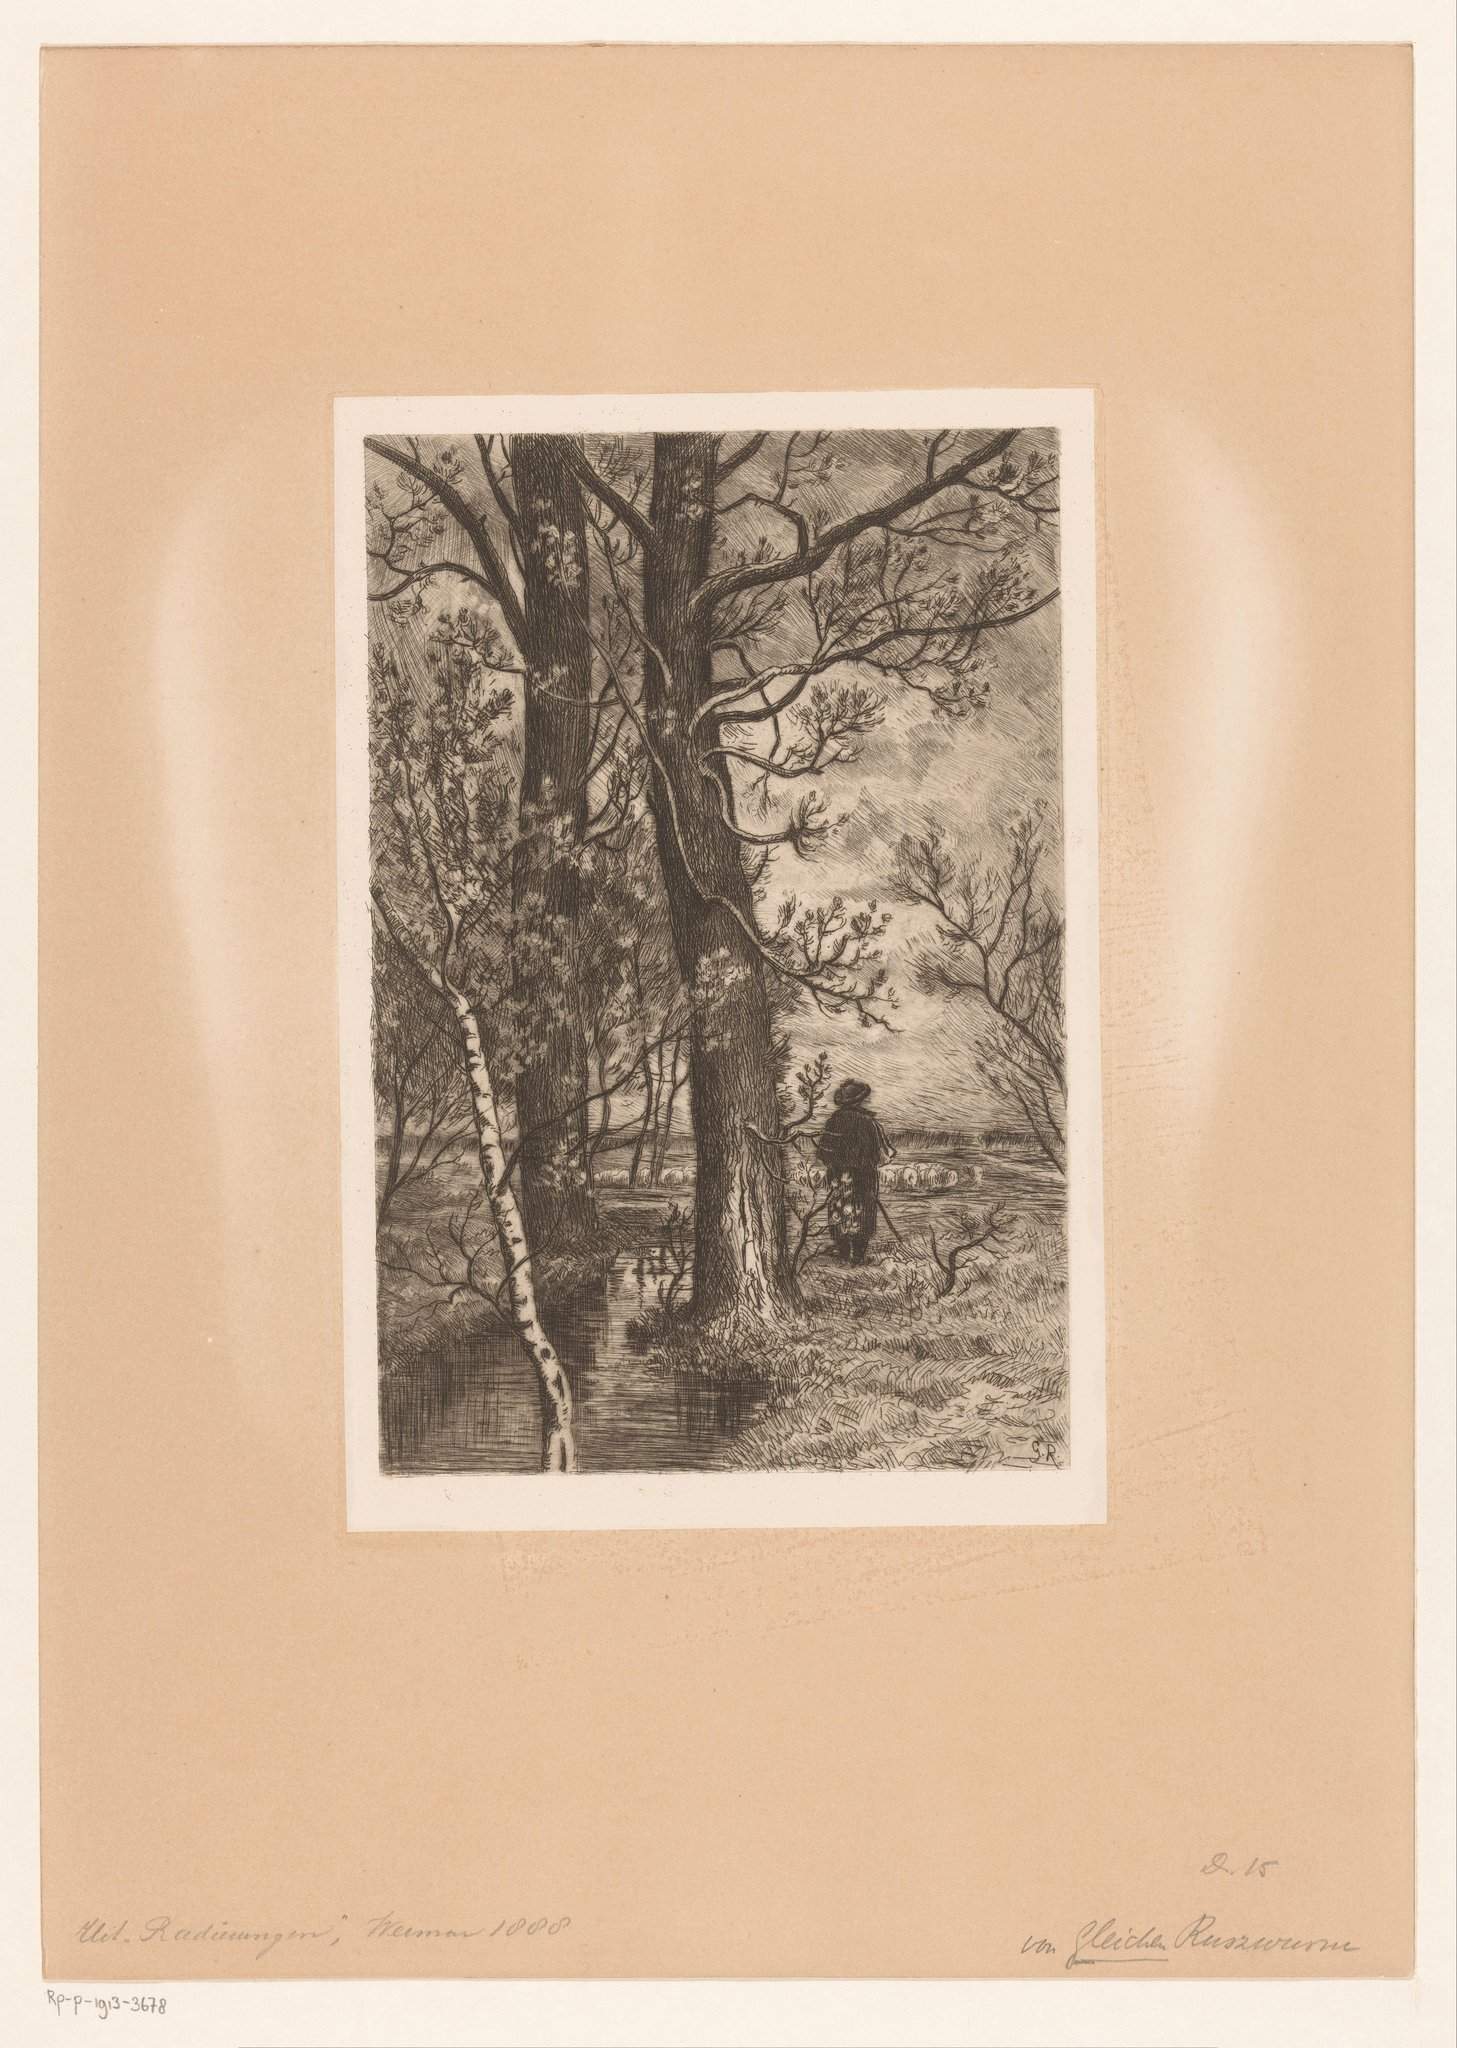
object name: print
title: Herder met zijn schapen bij twee bomen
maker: heinrich ludwig freiherr von gleichen-russwurm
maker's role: painter, print maker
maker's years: 1836-1901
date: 1888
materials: paper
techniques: drypoint, etching, intaglio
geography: weimar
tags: landscapes, herding, herdsman, herdswoman, shepherd, shepherdess, cowherd, etc., sheep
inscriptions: inscription: ‘Uit "Radirungen", Weimar 1888’, collector's mark: Lugt 2228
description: Prent maakt deel uit van een groep prenten die tussen 1880 en 1888 werd uitgegeven door het Gesellschaft für Radierkunst te Weimar.